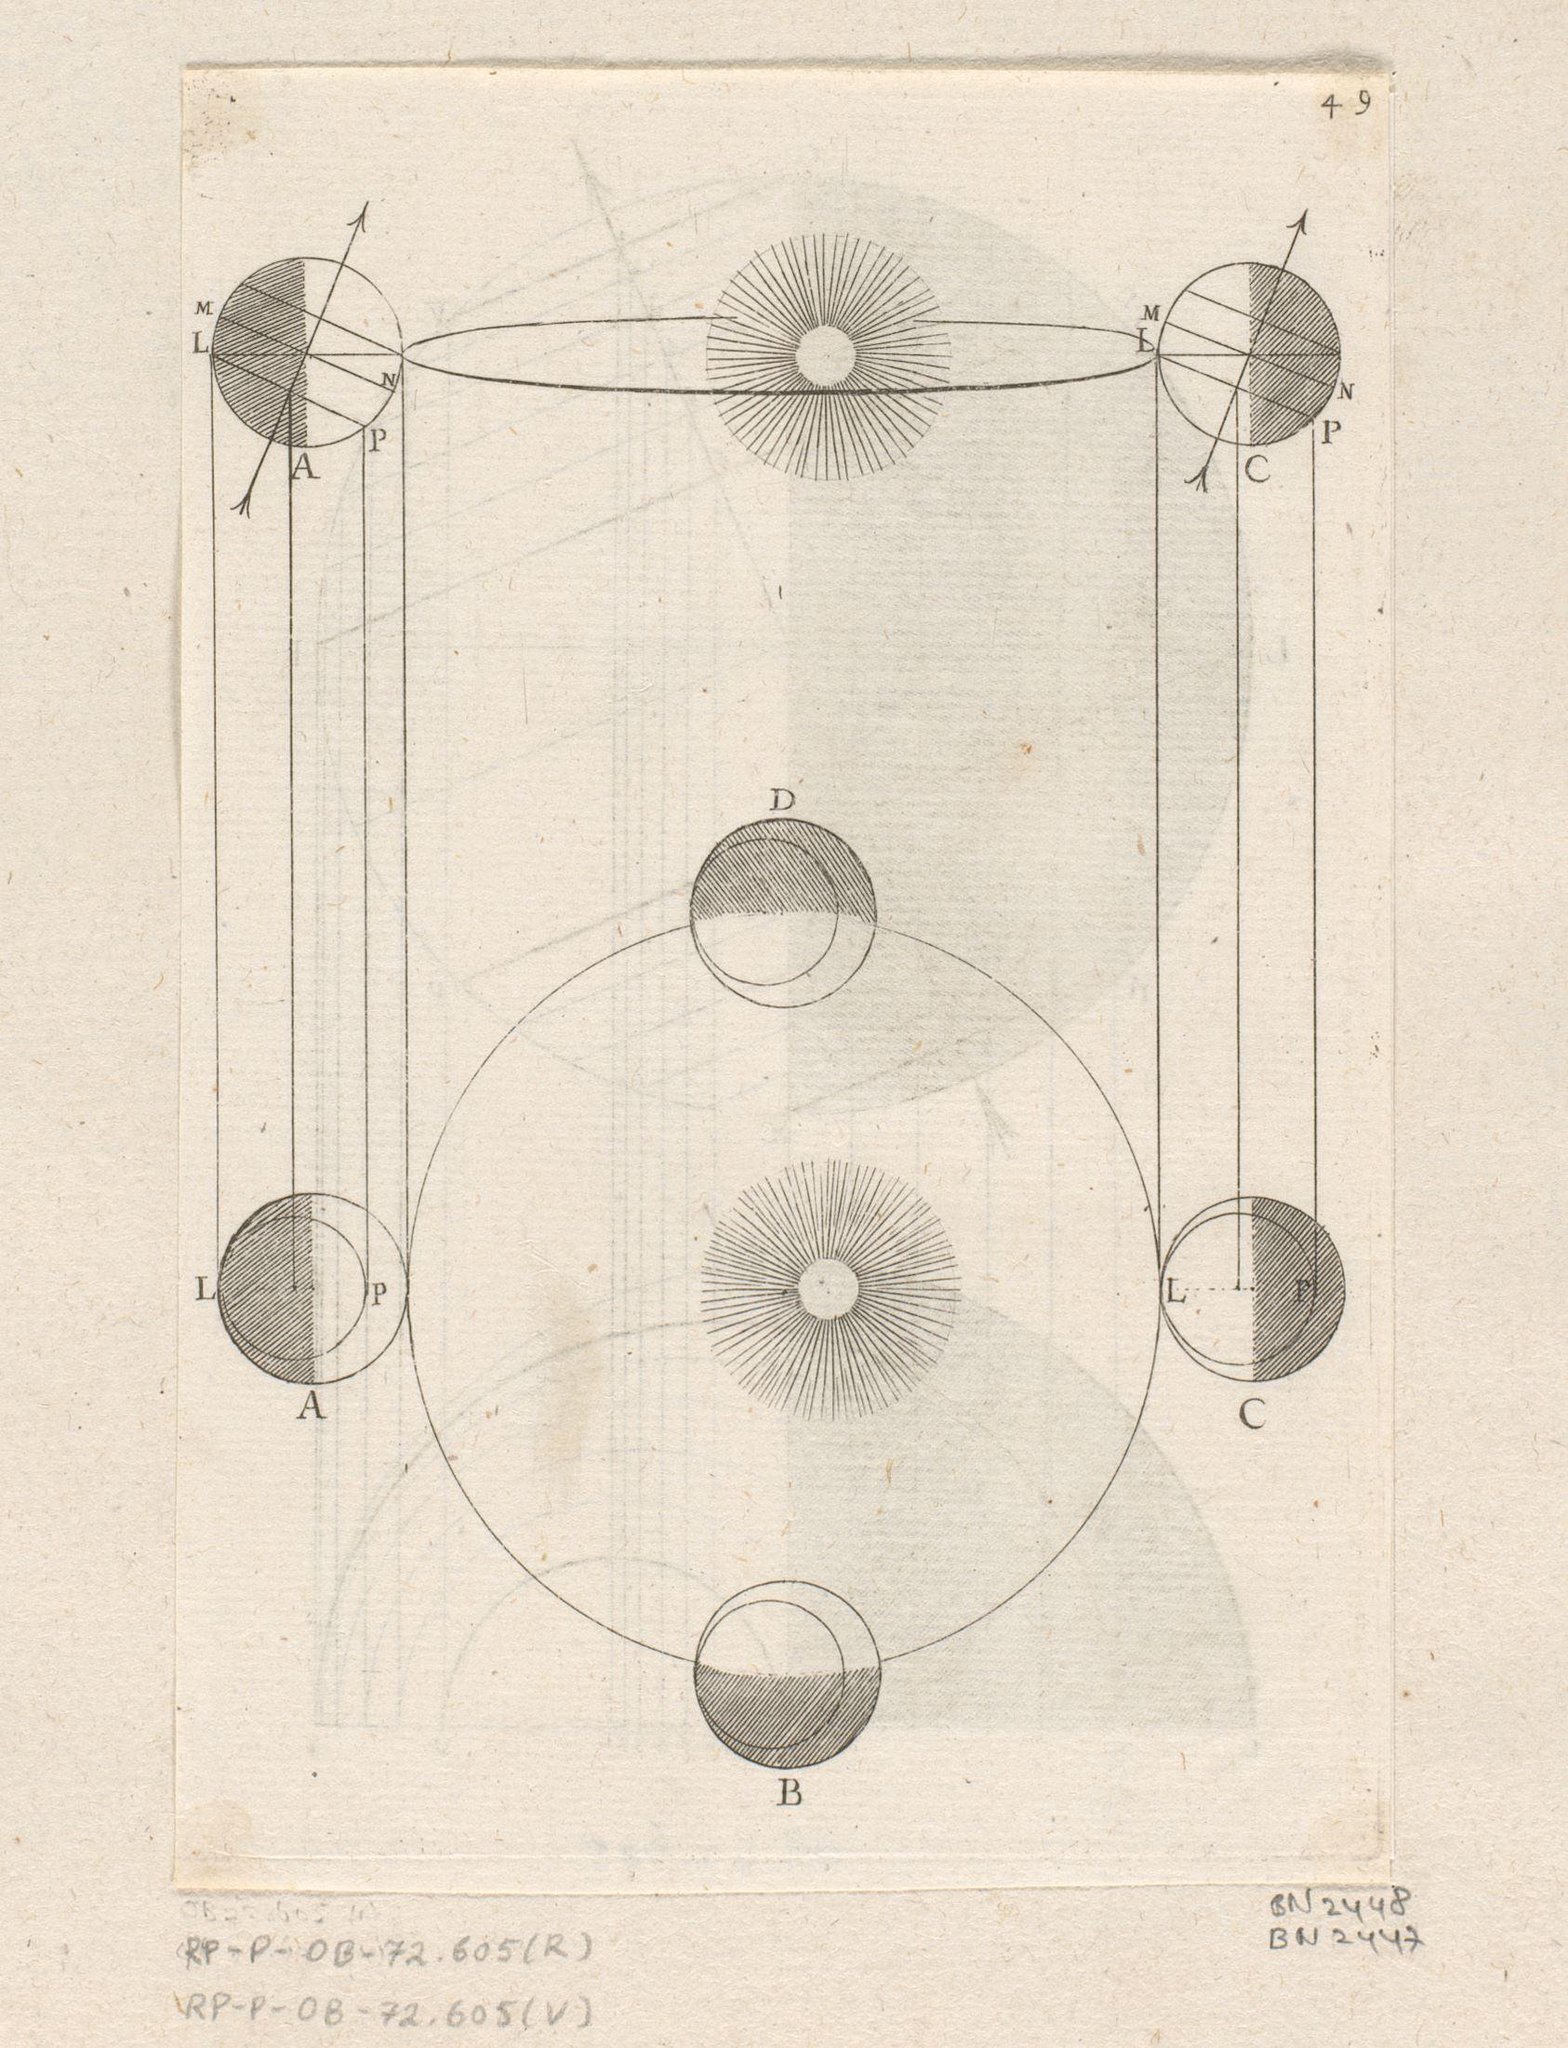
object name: print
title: Ongelijkheid tussen dagen en nachten met onderaan vier posities van de Aarde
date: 1706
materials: paper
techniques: etching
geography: paris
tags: earth, world as celestial body, day and night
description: Prent uit: Leclerc, Sébastien. Nouveau systeme du monde conforme à l'Ecriture sainte. Où les phénomènes sont expliquez sans excentricité de mouvement (...). Paris: Pierre Giffart, 1706.